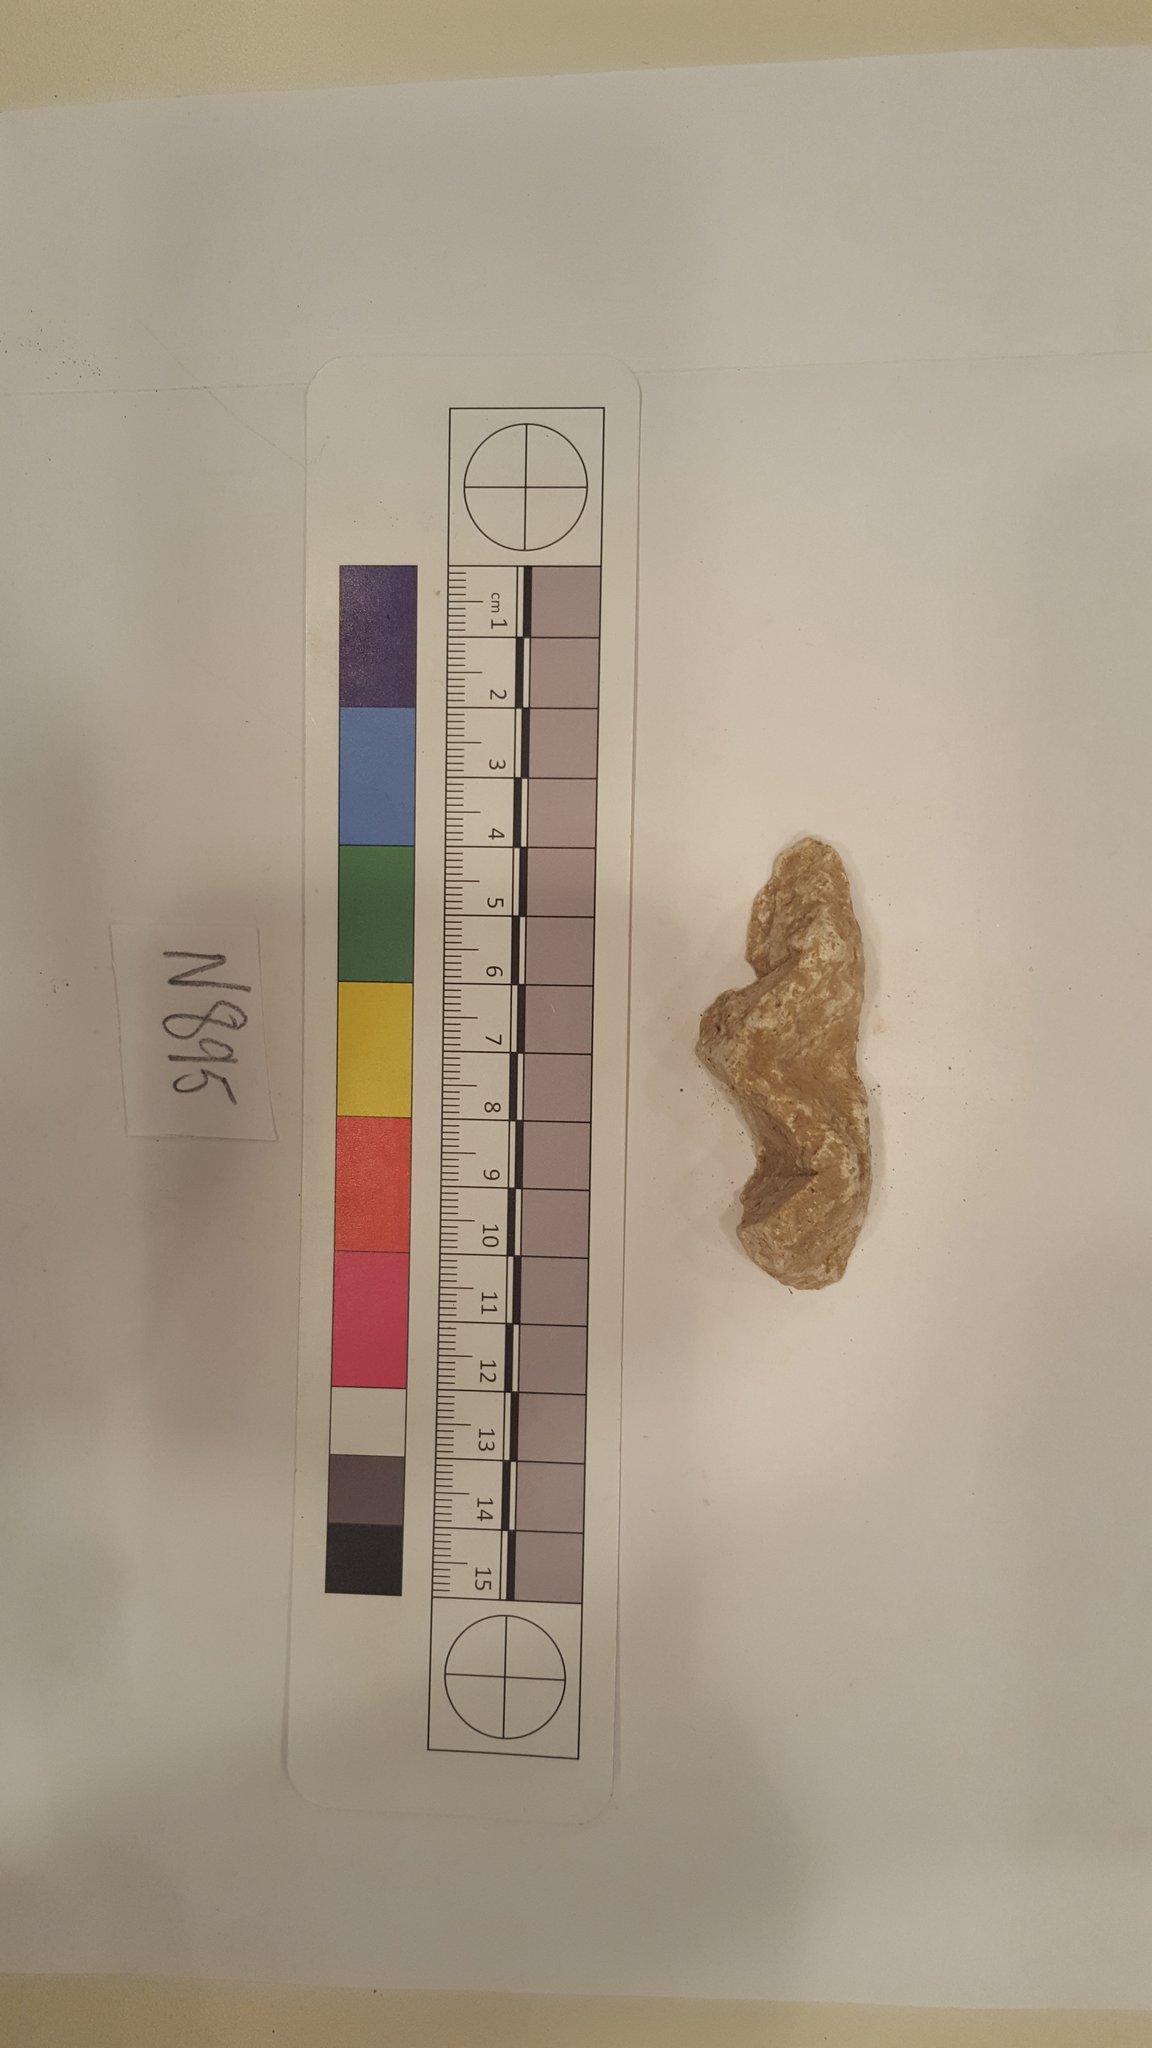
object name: fragment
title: Stucco Fragment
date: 701-1200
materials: plaster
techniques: carving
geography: iran